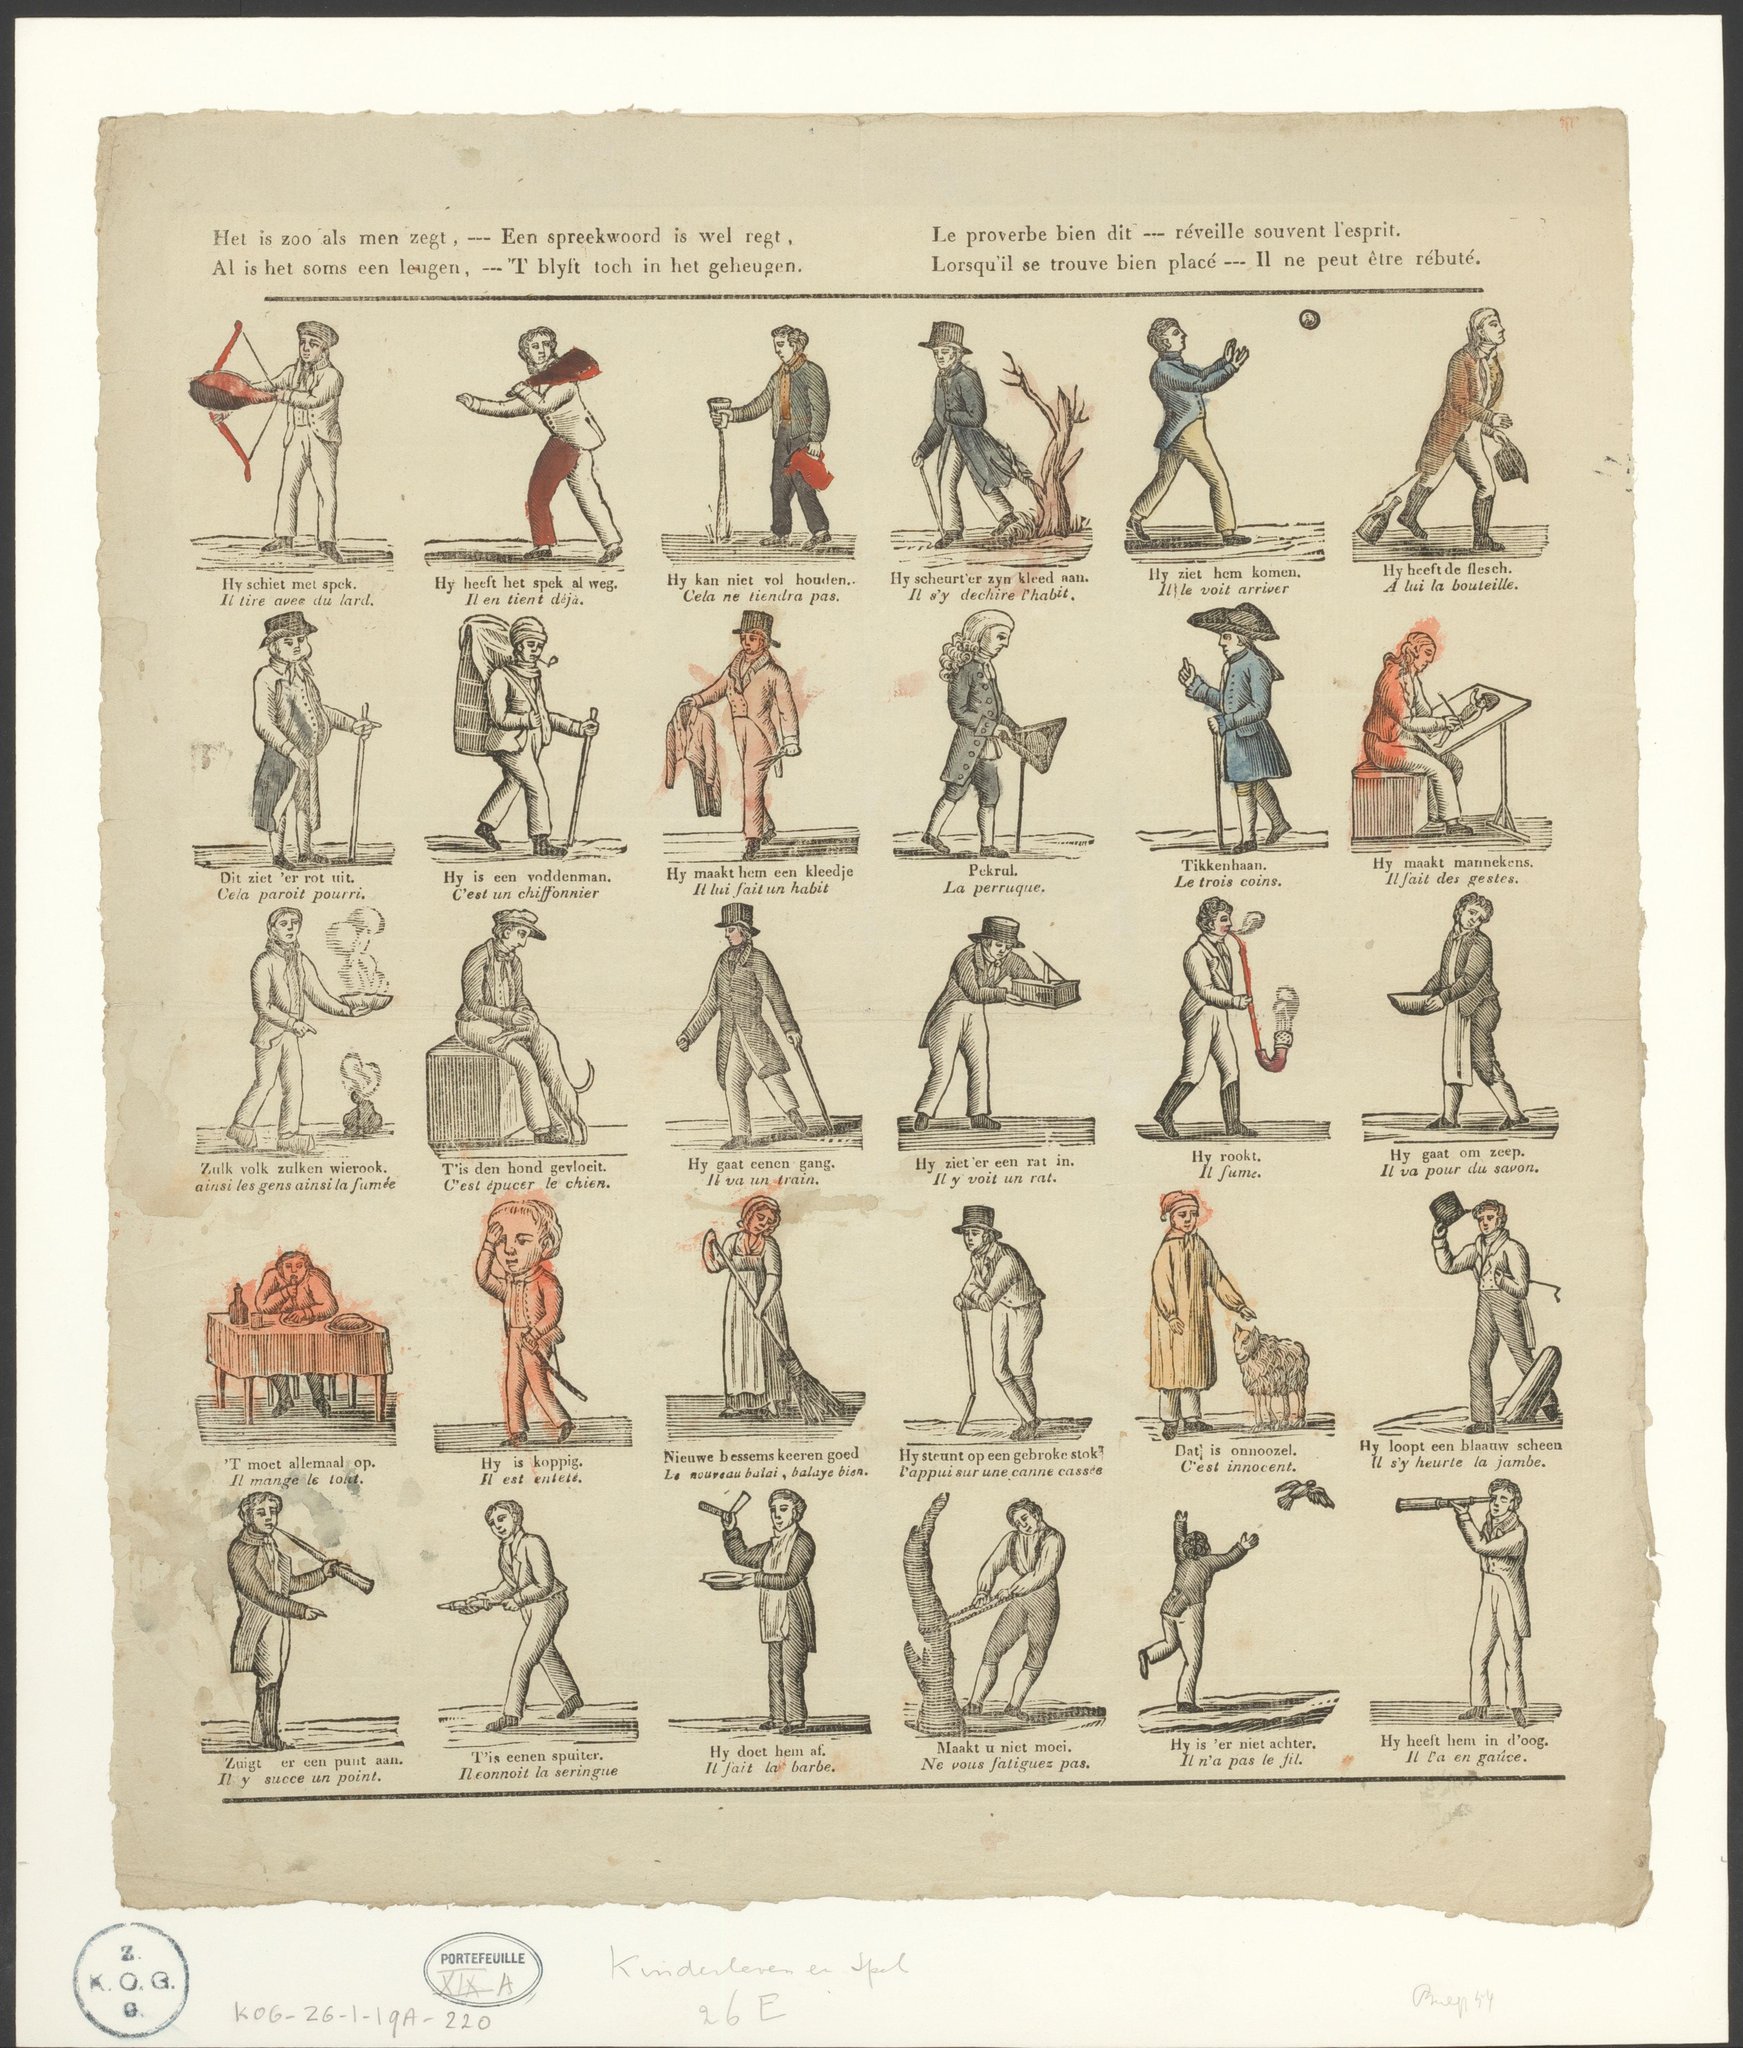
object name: print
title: Het is zoo als men zegt, - Een spreekwoord is wel regt (...) / Le proverbe bien dit - réveille souvent l'esprit (...)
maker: Anonymous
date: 1800-1854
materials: paper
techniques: letterpress printing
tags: characters (human types), proverbs, sayings, etc.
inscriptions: collector's mark: Lugt 1641, stamp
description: Dertig voorstellingen van spreekwoorden en uitdrukkingen. Onder elke afbeelding een onderschrift in het Nederlands en in het Frans. Onderwerpsrubrieken binnen de Atlas Zeden en Gewoonten: Zeden en Gewoonten in Engeren Zin, Des menschen beging, midden en einde, Kinderleven – Kinderspel en Kinderprenten.